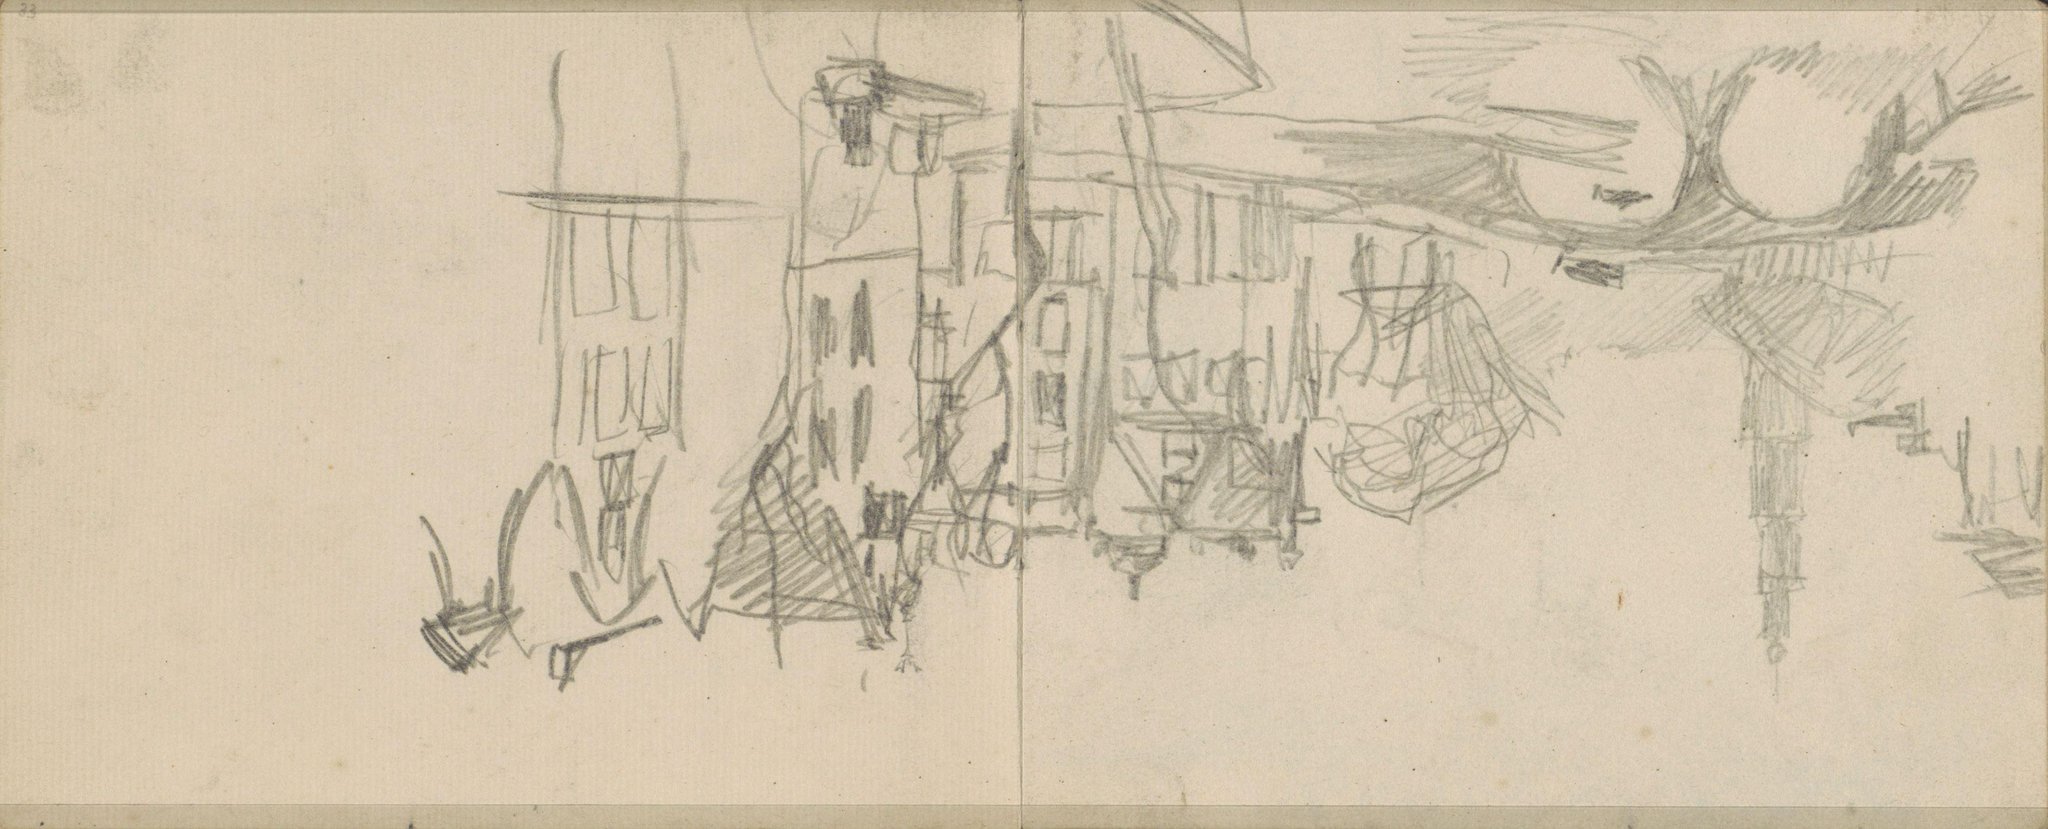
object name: sketchbook leaf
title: Brouwersgracht te Amsterdam met de brug over de Prinsengracht en de Westertoren, gezien vanaf de Eenhoornsluis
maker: george hendrik breitner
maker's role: draughtsman, painter, print maker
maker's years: 1857-1923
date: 1886-1895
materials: paper, pencil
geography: amsterdam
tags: urban housing, canals, waters (in city), parts of church exterior and annexes: tower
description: Pagina 33 en pagina 34 uit een schetsboek met 34 bladen.